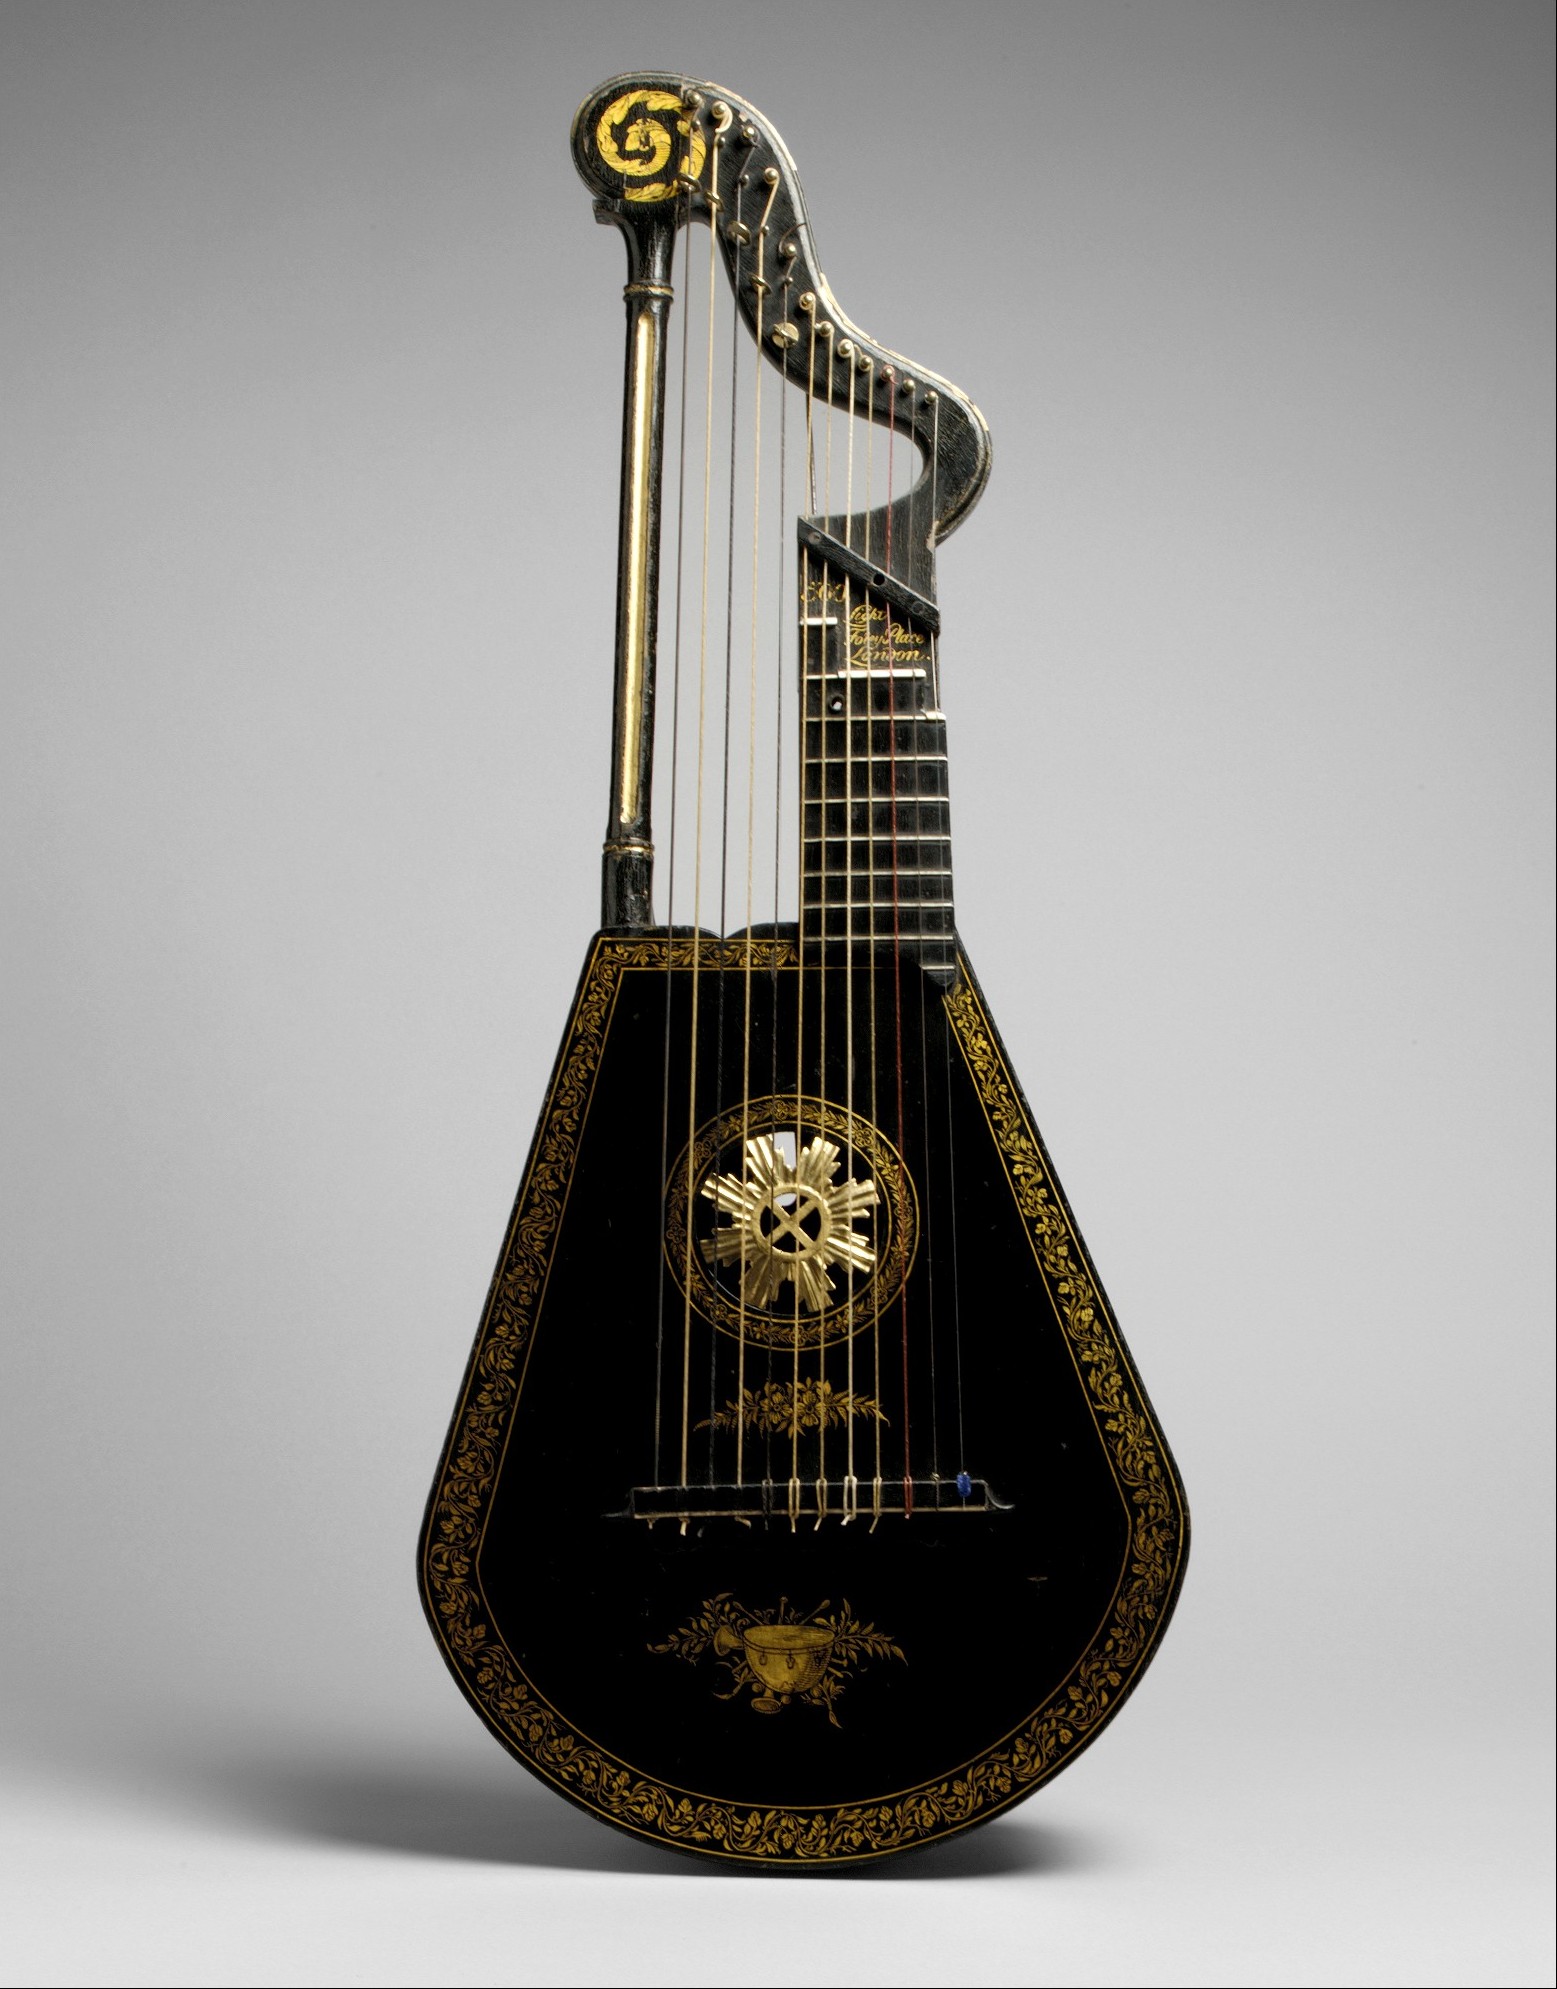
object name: harp lute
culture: british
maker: edward light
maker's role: maker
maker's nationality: british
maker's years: 1747-1832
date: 1815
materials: wood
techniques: gilding, lacquer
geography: united kingdom